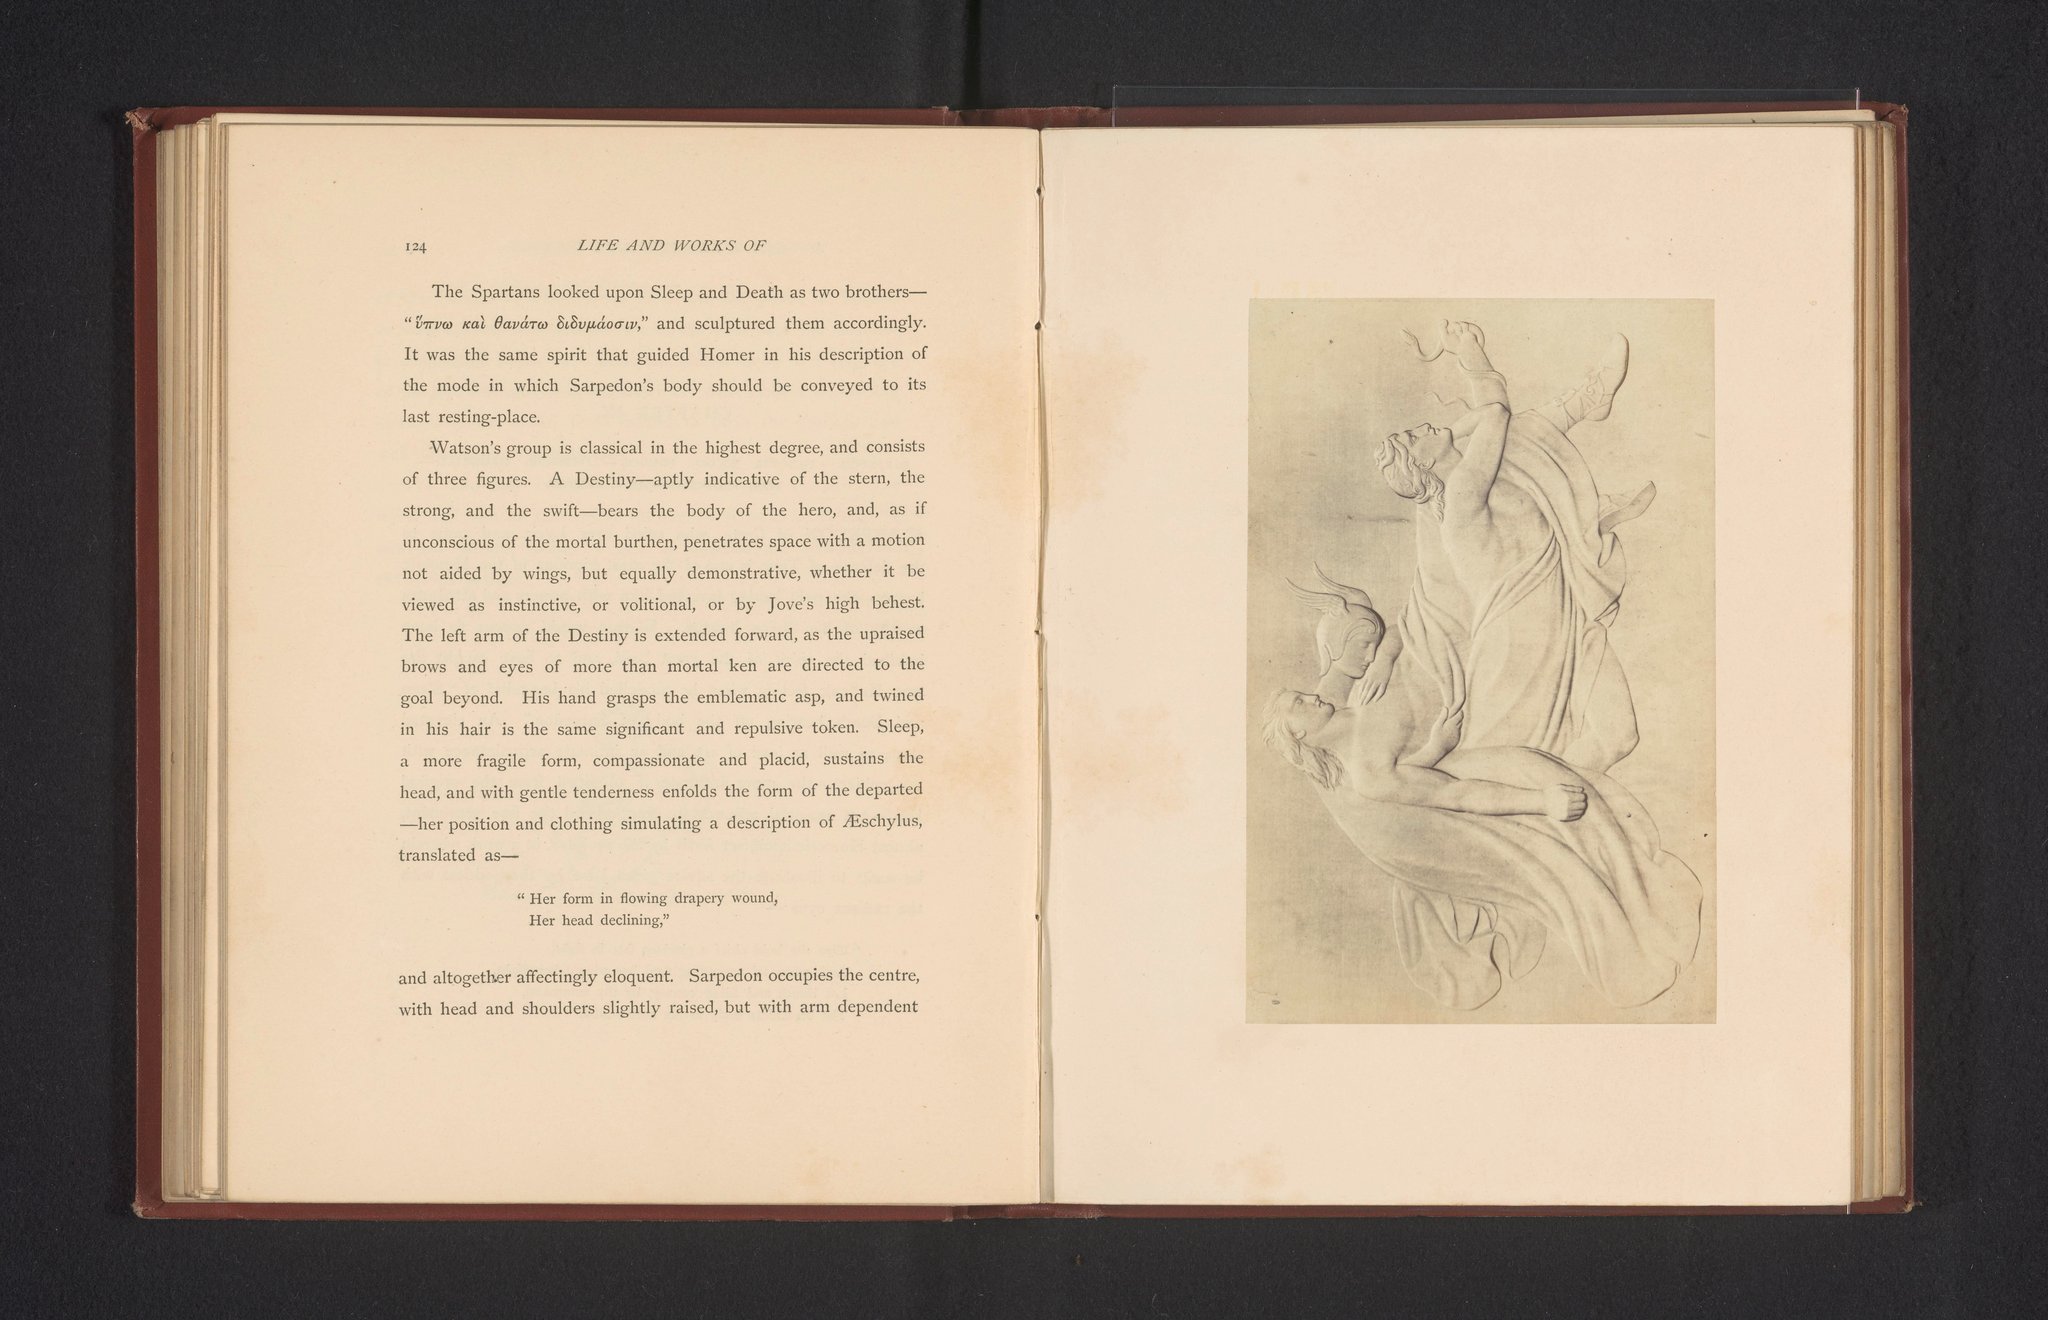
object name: page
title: Reliëf, voorstellende de Slaap en de Dood dragen het lichaam van Sarpedon weg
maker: Anonymous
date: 1861-1866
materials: photographic support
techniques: albumen print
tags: the body of sarpedon is carried through the air by hypnos and thanatos, sculpture (+ relief ~ sculpture)